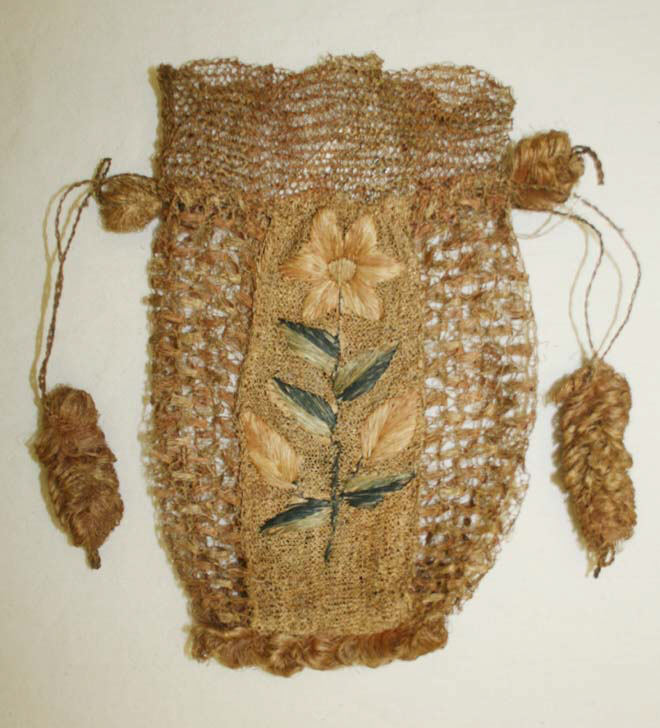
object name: drawstring bag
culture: american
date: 1767-1833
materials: fiber, hemp